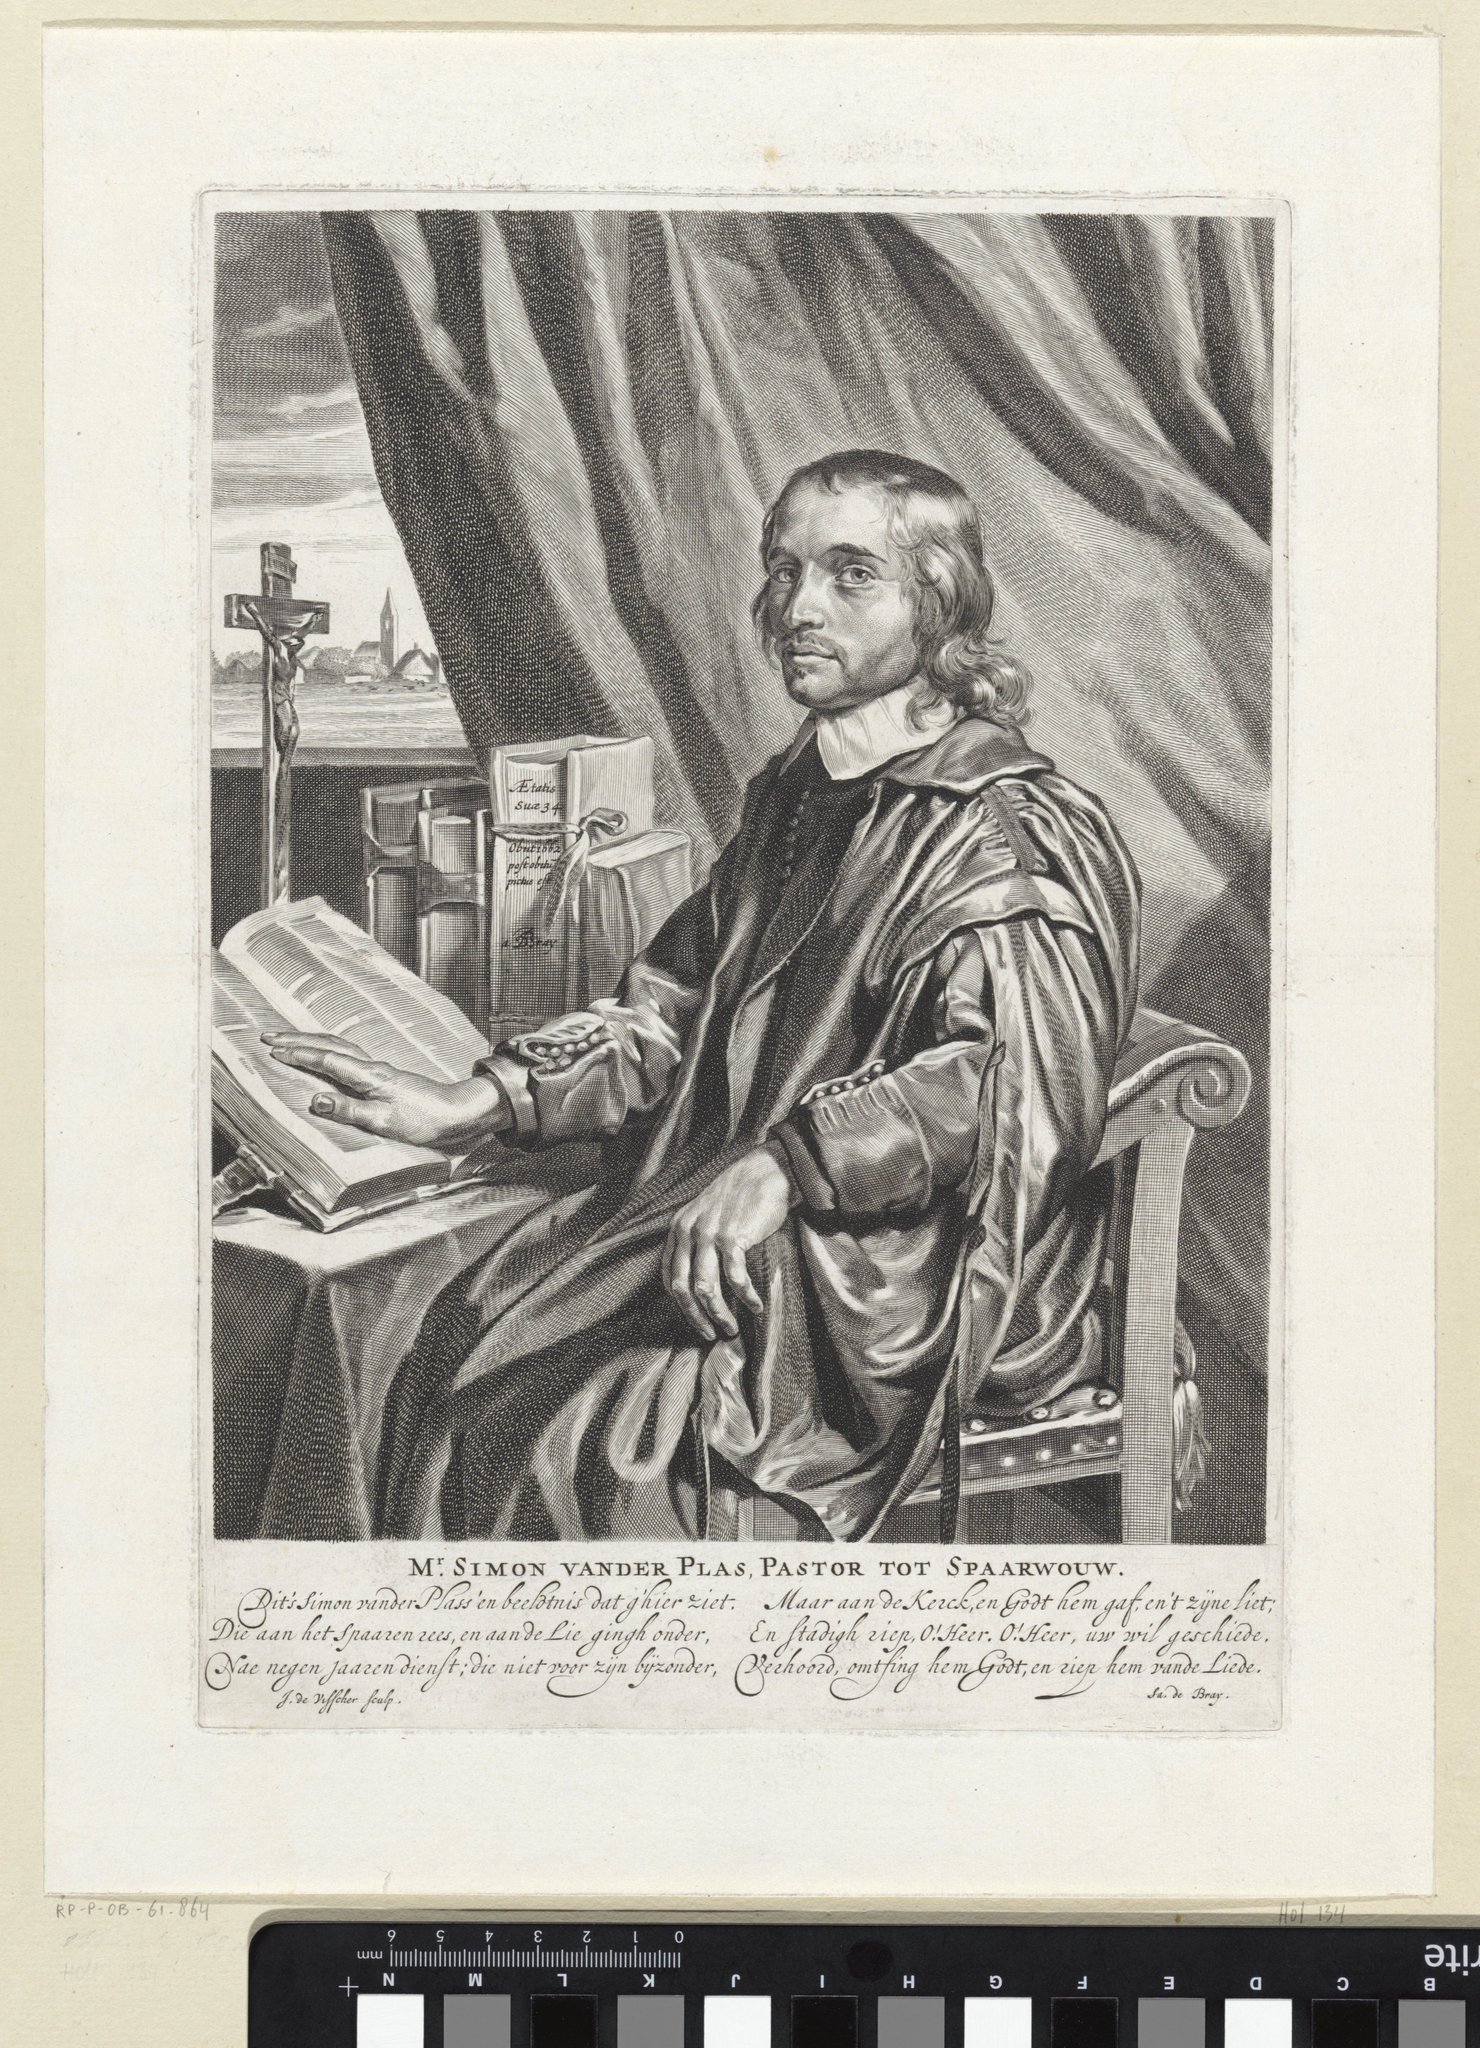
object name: print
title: Portret van Simon van der Plas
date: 1662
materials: paper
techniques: engraving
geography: northern netherlands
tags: book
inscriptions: collector's mark: Lugt 240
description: De pastoor Simon van der Plas, zittend aan een tafel met boeken en een crucifix. Op de achtergrond een gezicht op een dorp, mogelijk Spaarnwoude.